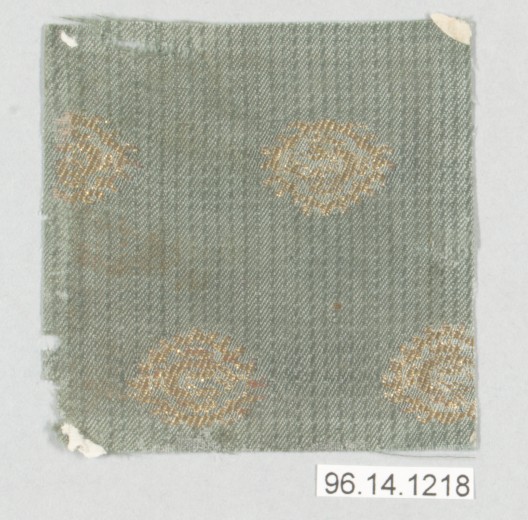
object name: piece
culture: japanese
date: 1701-1900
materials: silk